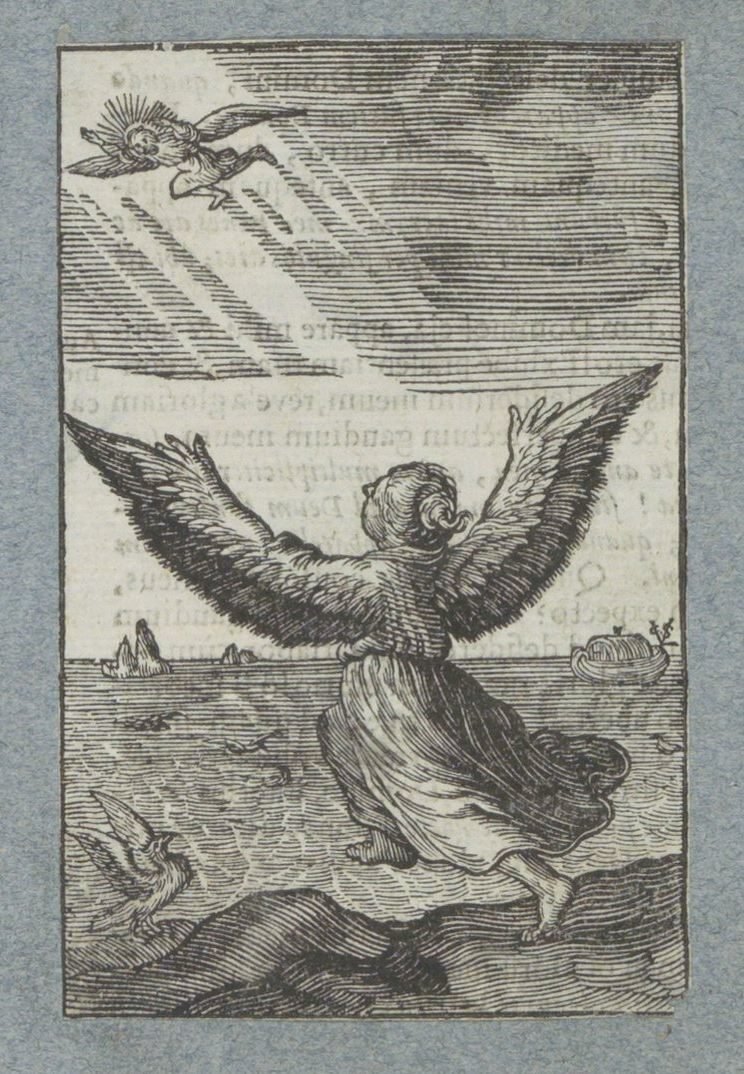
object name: album leaf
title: Pia Desideria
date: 1628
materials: paper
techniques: letterpress printing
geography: antwerp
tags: abstract ideas and concepts (+ clothed with wings)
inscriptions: collector's mark: Lugt 2165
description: Prent uit: Herman Hugo, Pia desideria emblematis, elegiis & affectibus S. S. Patrum illustrata, Antwerpen 1628. Volgens de titelpagina verscheen dit werk in Antwerpen bij Hendrick Aertssens, in werkelijkheid verscheen het in Amsterdam bij Pieter Jacobsz Paets (Dietz 2012, p. 58-59).